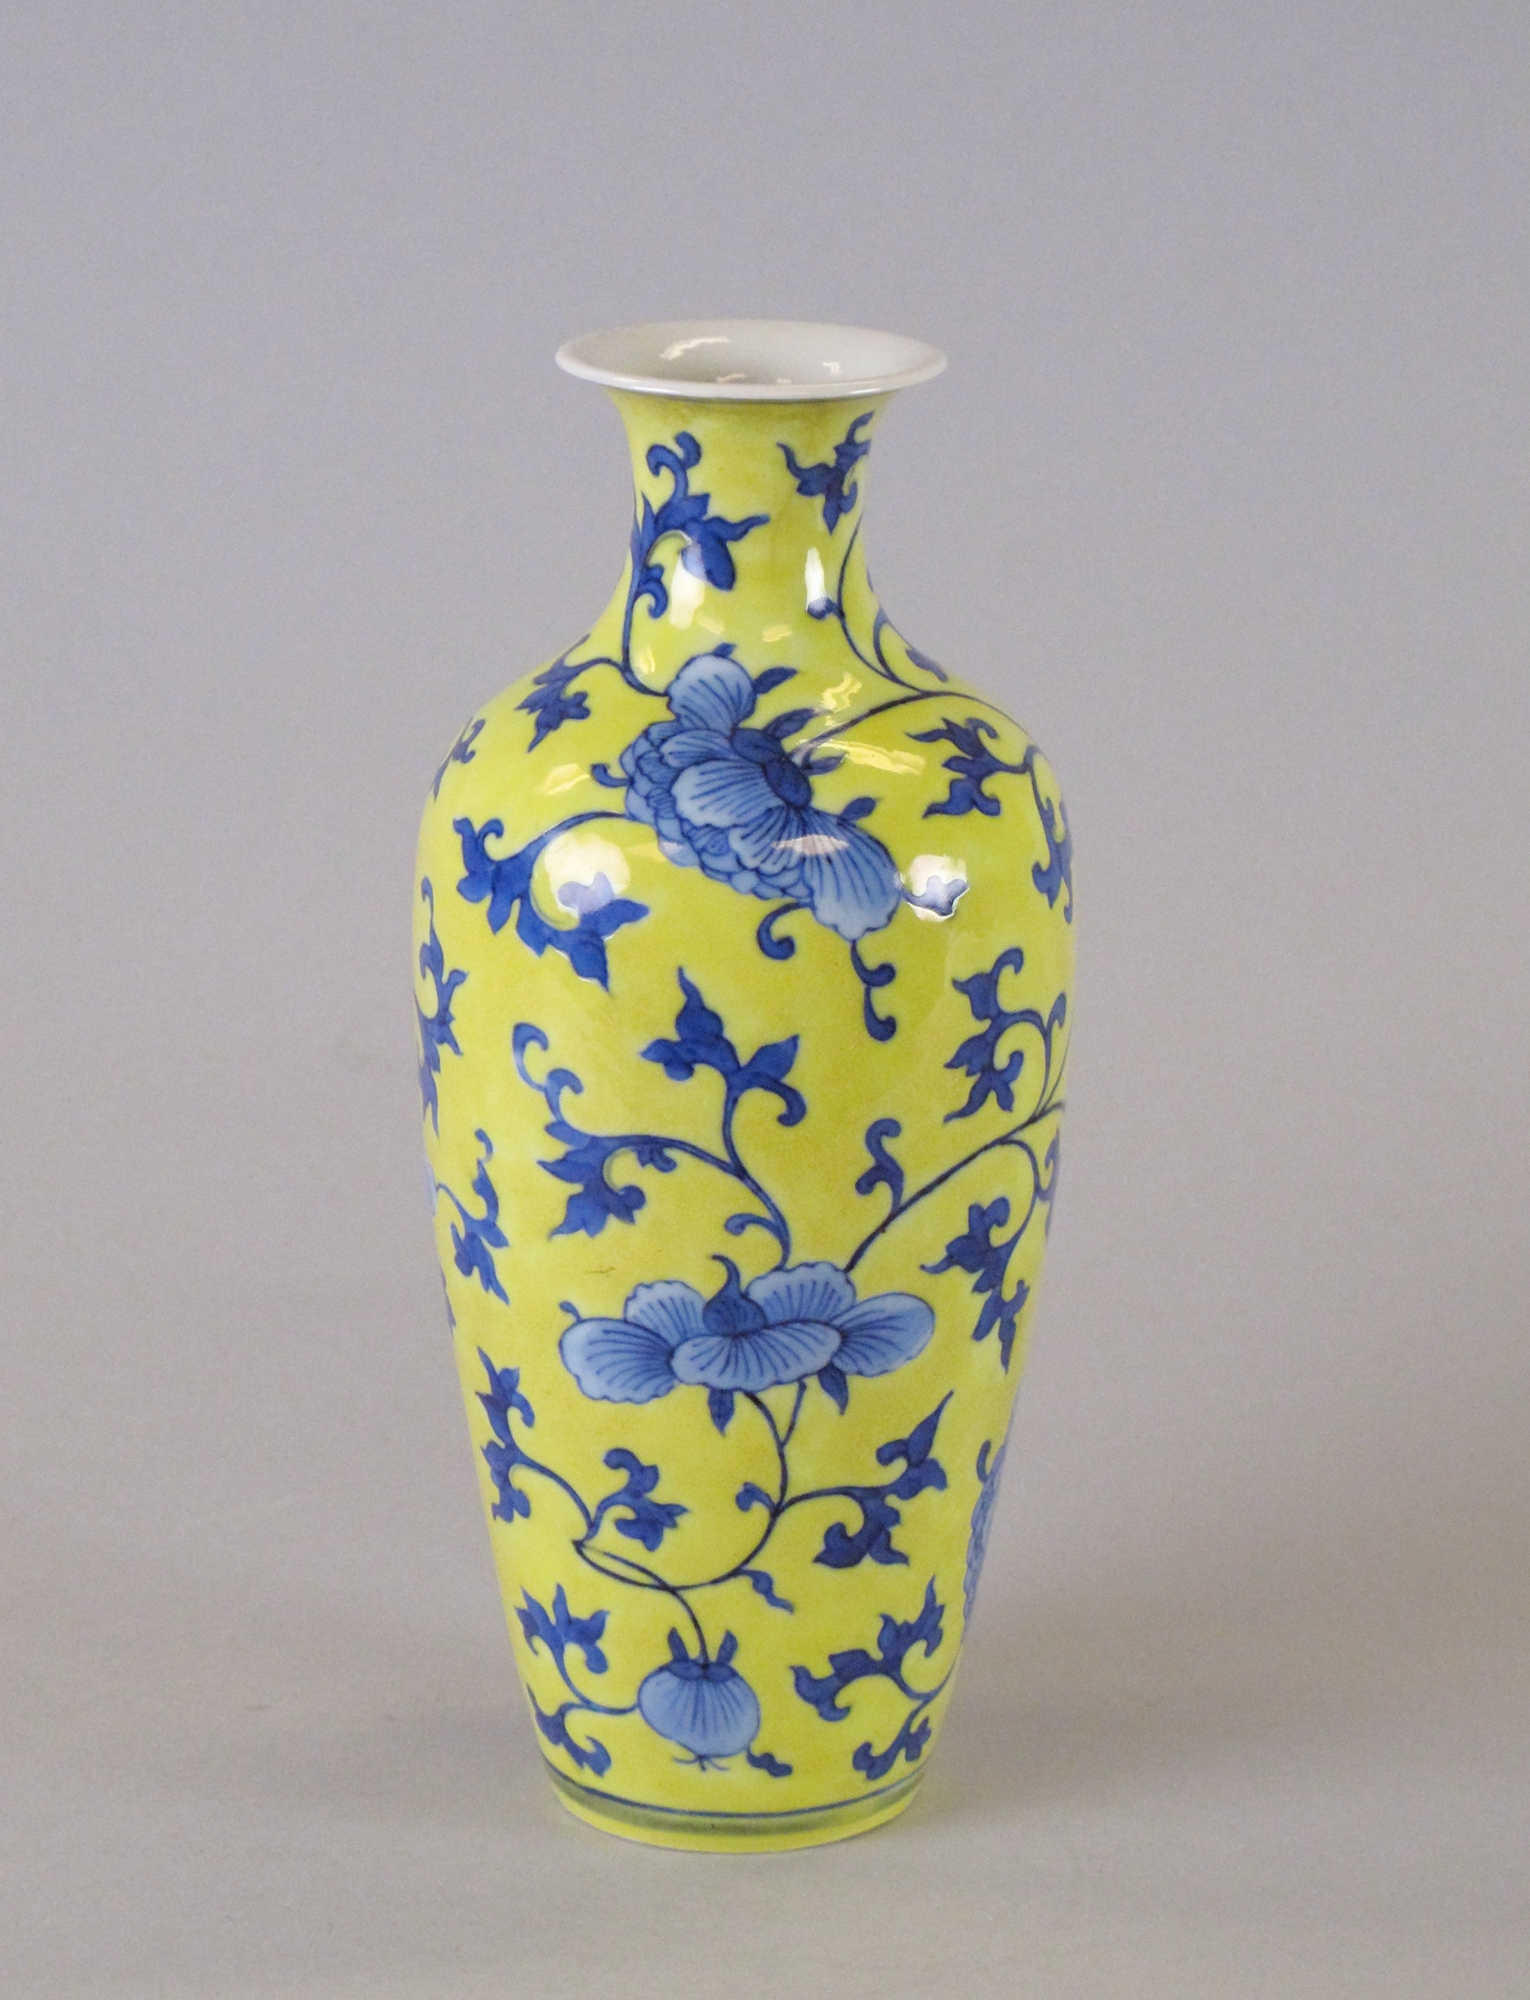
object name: vase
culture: chinese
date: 1801-1850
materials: enamel, porcelain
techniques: overglaze, painting, underglaze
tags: flowers